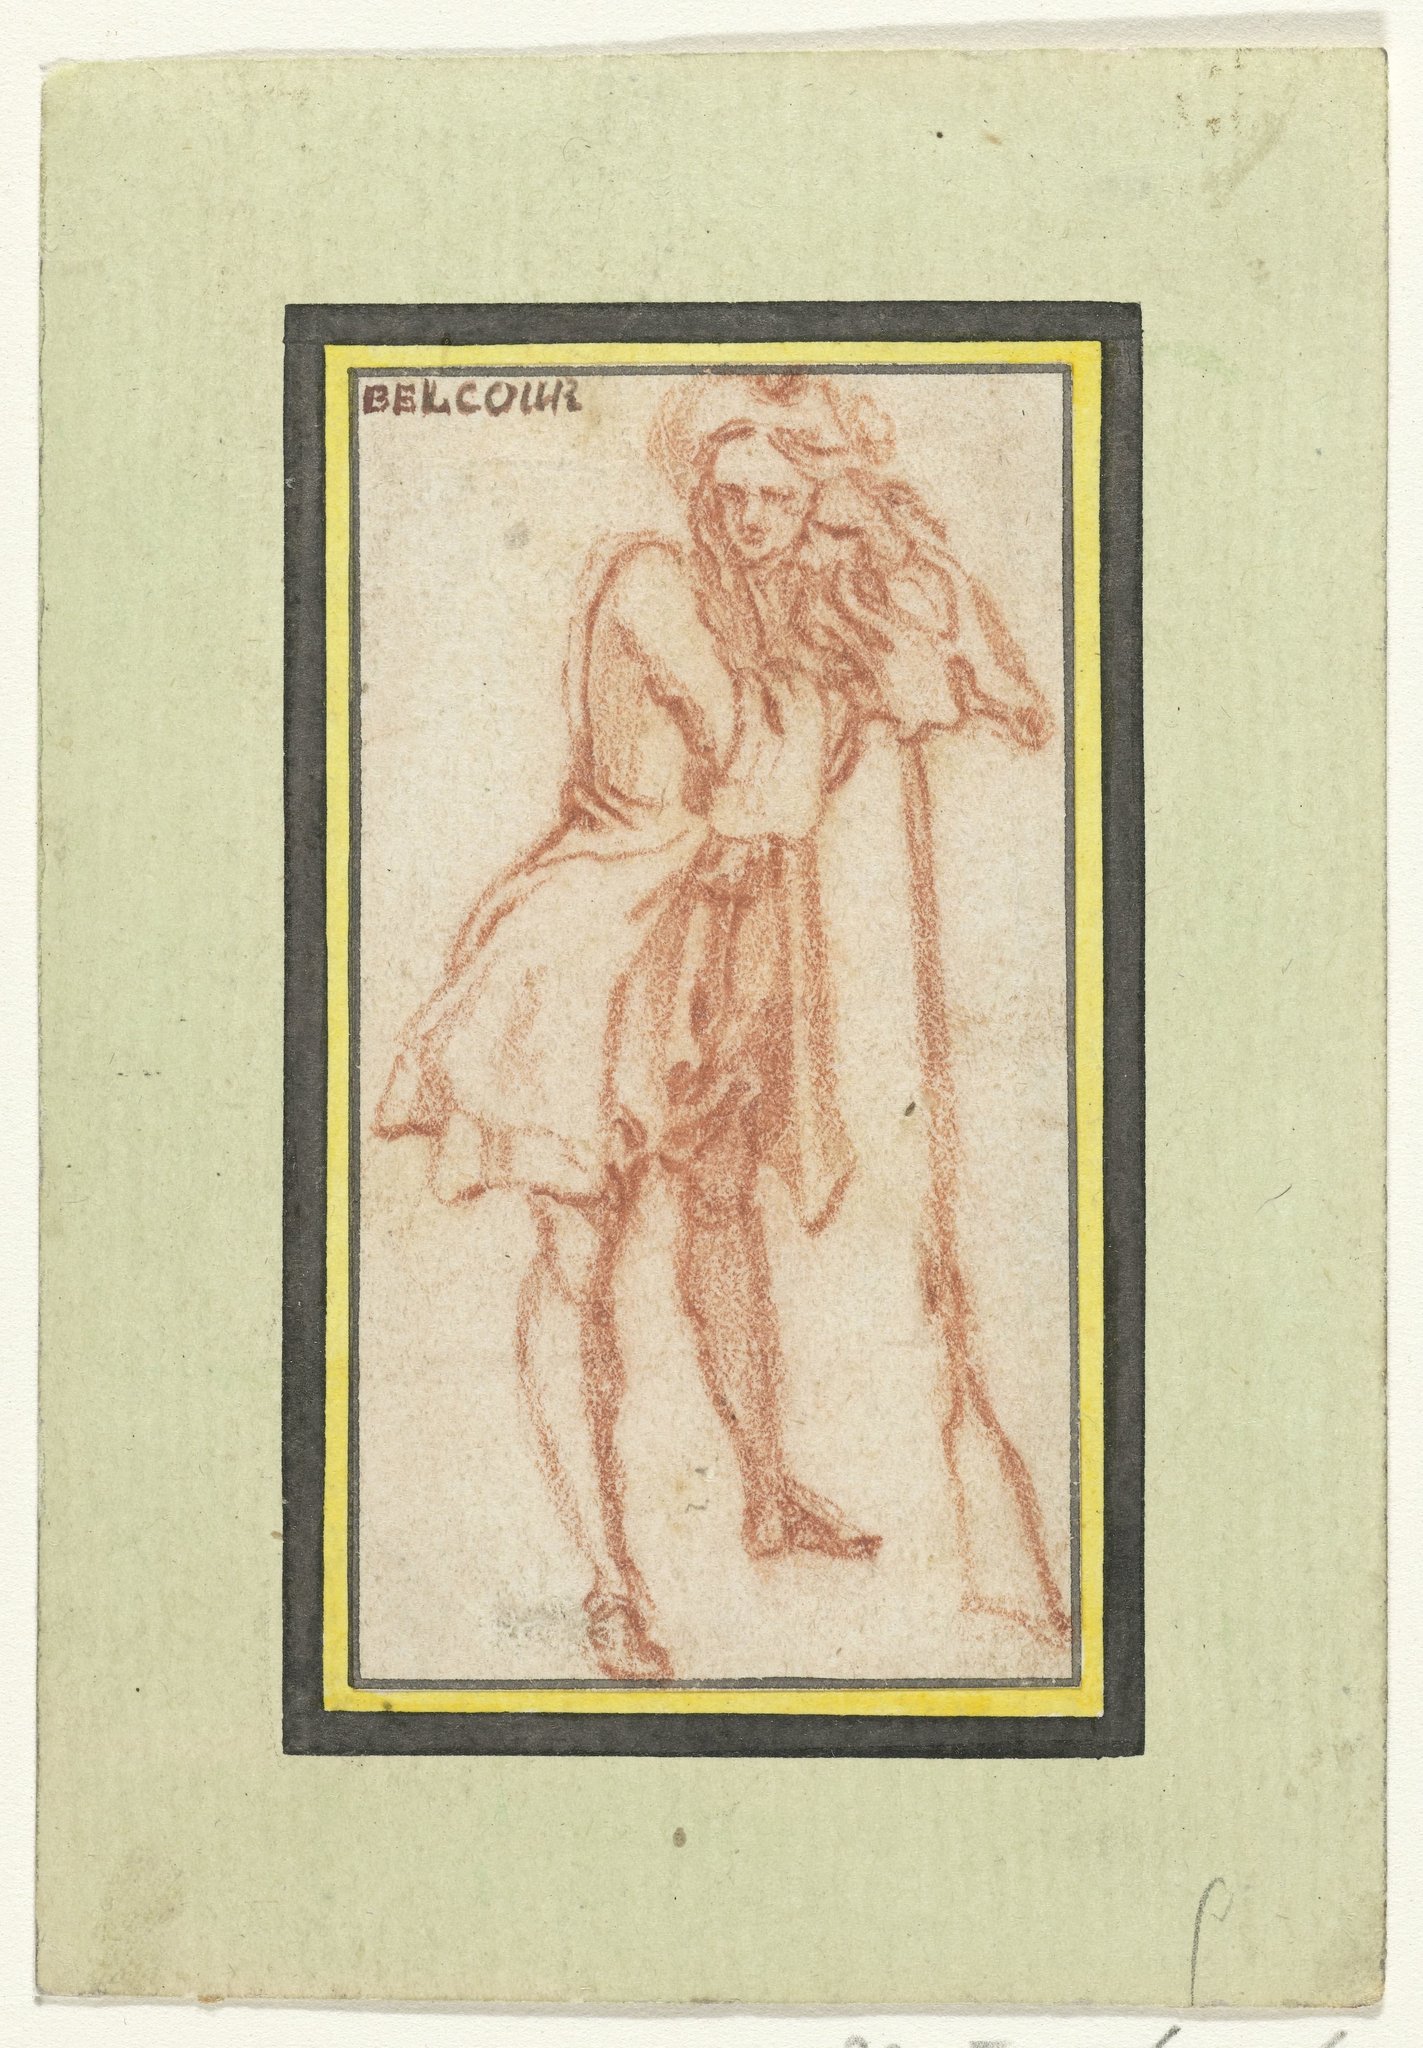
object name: drawing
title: Soldaat leunend op zijn geweer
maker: pierre antoine quillard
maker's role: draughtsman, print maker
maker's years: 1701-1733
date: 1711-1733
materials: chalk, paper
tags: firearms: rifle, the soldier; the soldier's life, leaning figure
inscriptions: collector's mark, verso, lower centre: Lugt 2228, inscription, recto, upper right, pen and brown ink: ‘BELCOUR’